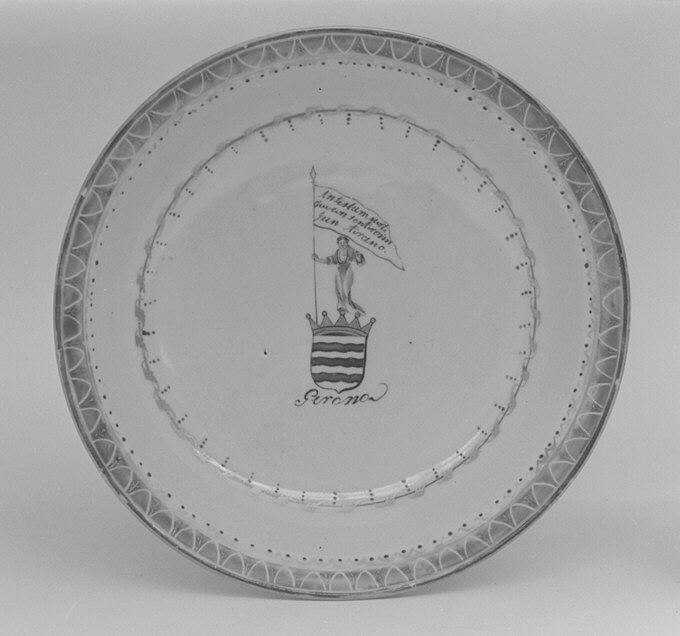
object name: saucer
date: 1810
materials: hard paste porcelain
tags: human figures,coat of arms,flags